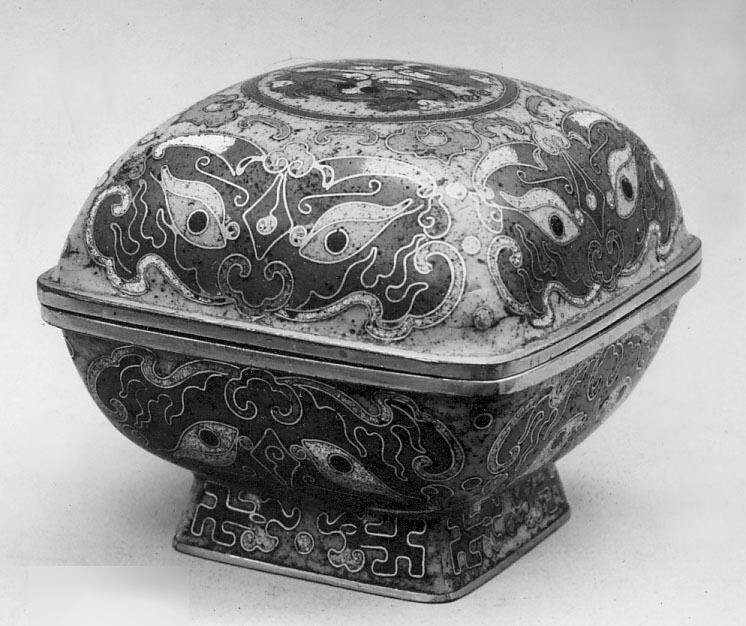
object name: covered box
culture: chinese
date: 1701-1800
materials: enamel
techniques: enamel, painting